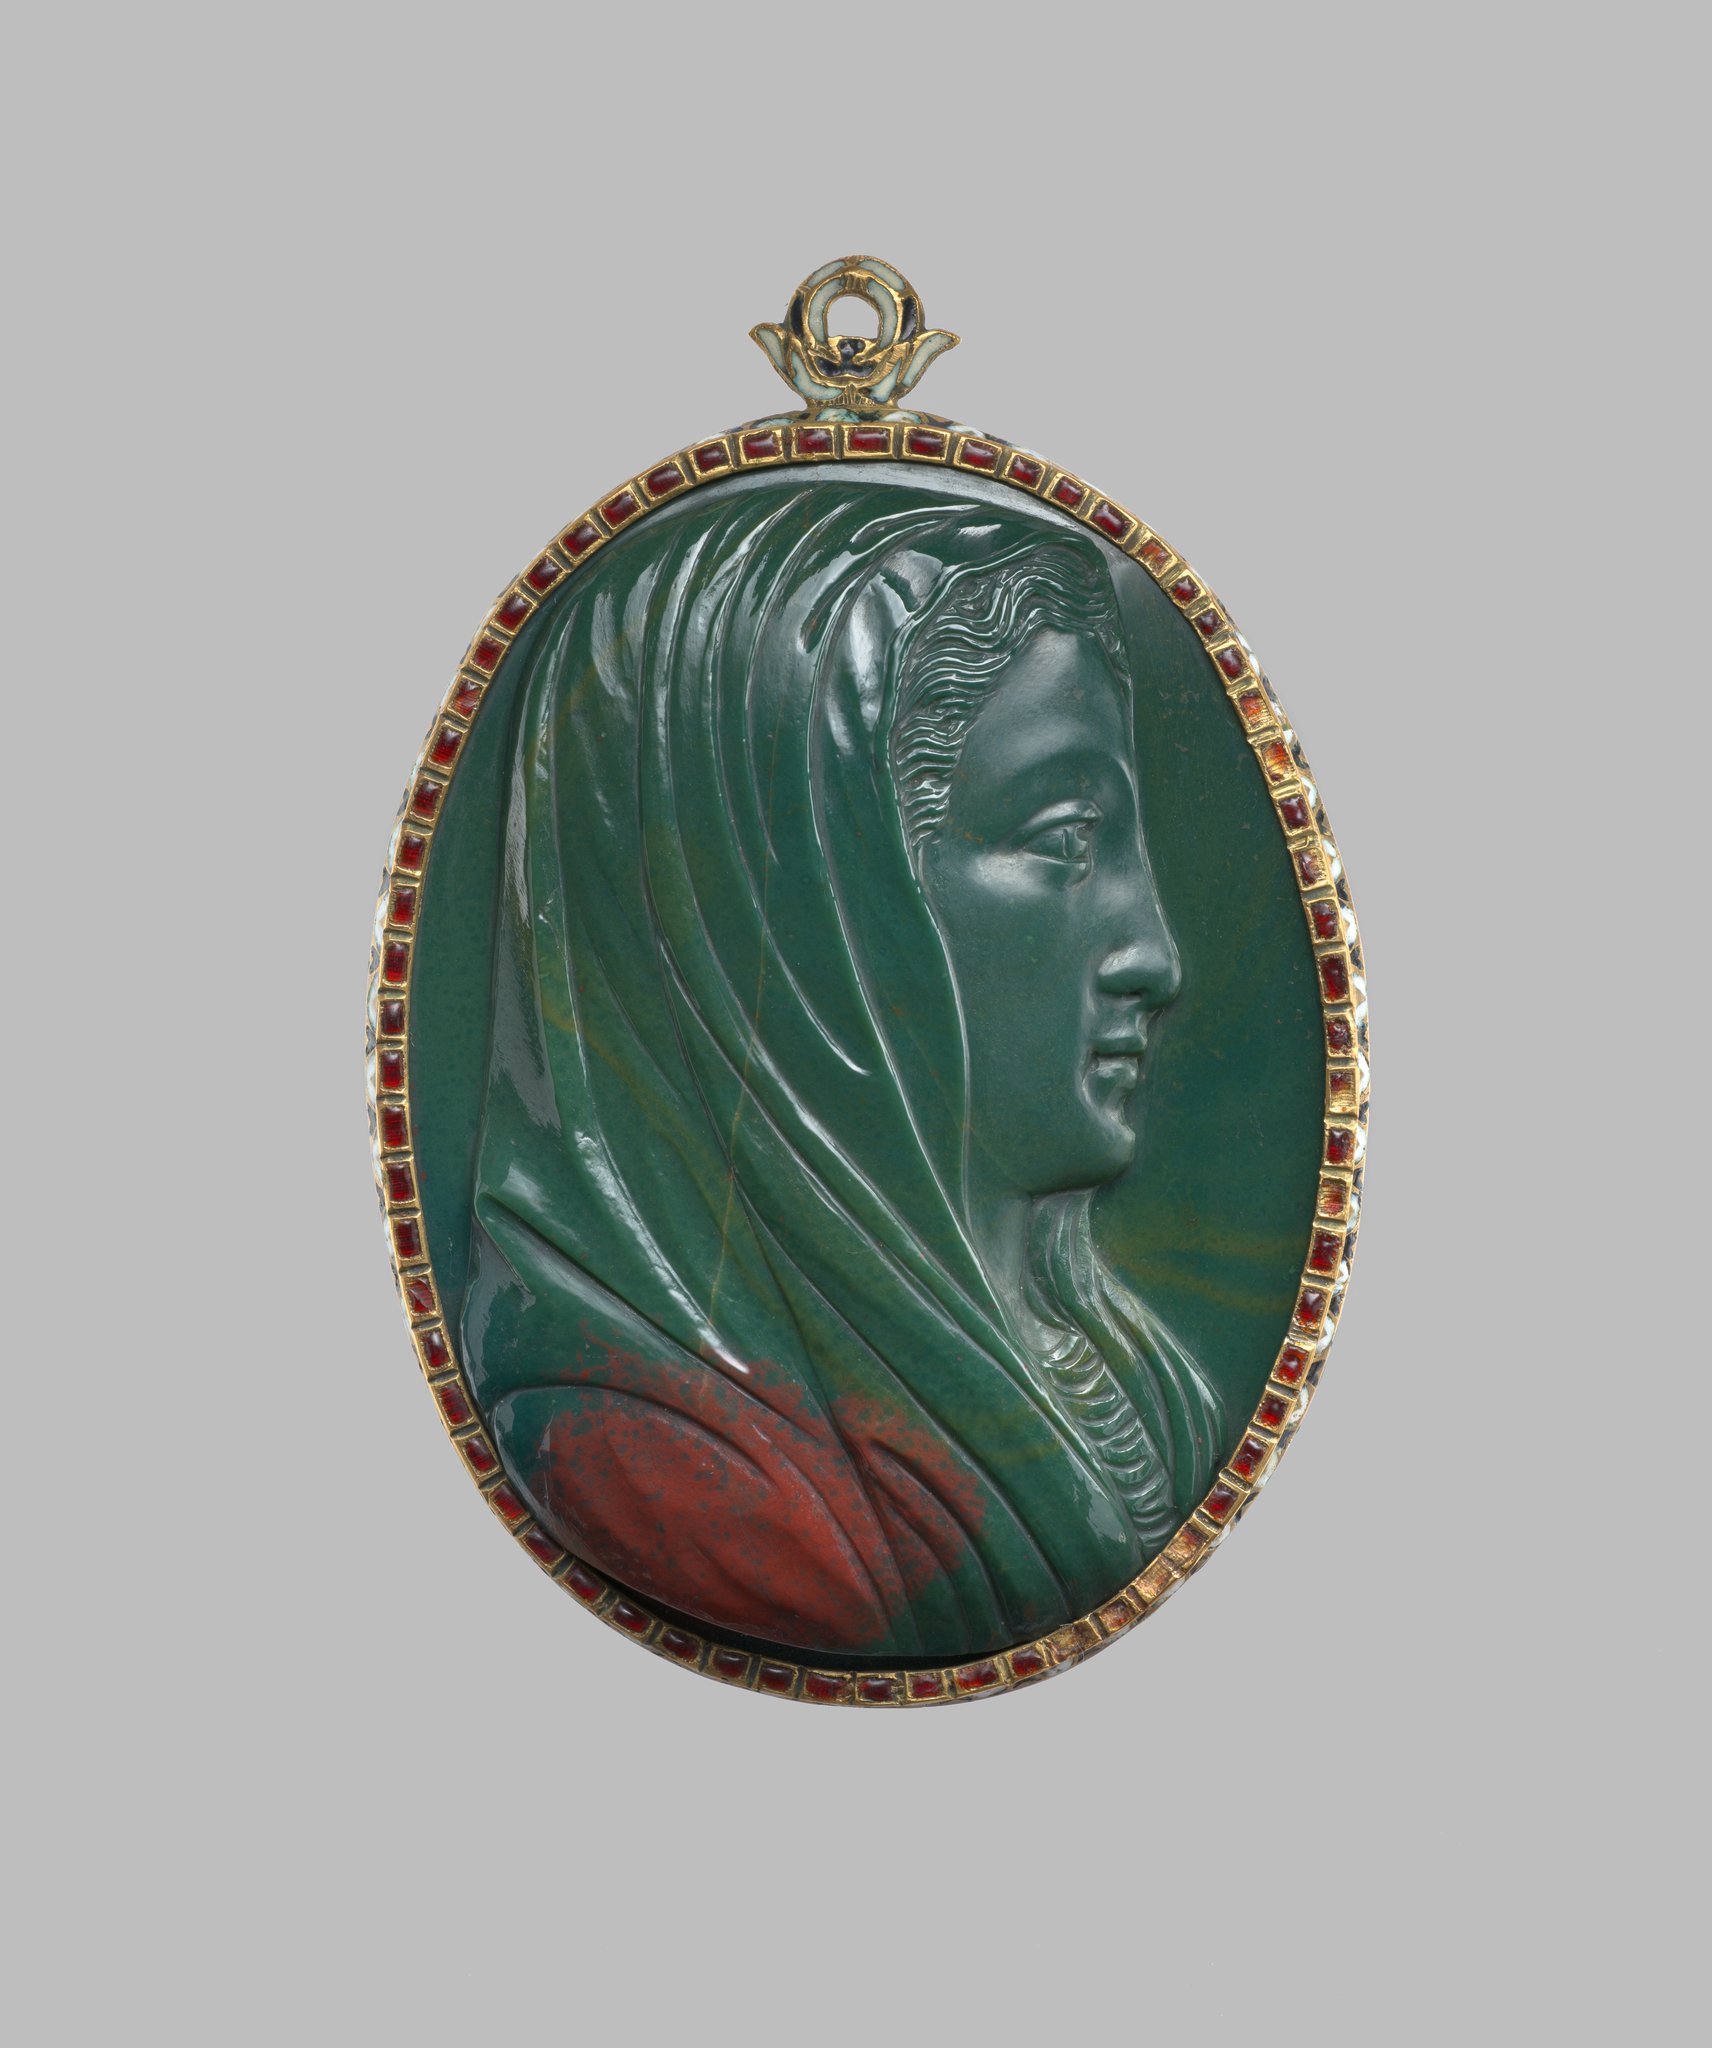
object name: pendant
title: Pendant with head of the Virgin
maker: ottavio miseroni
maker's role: maker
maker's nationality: italian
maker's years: 1567-1624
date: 1601-1633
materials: gold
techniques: enamel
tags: heads,virgin mary